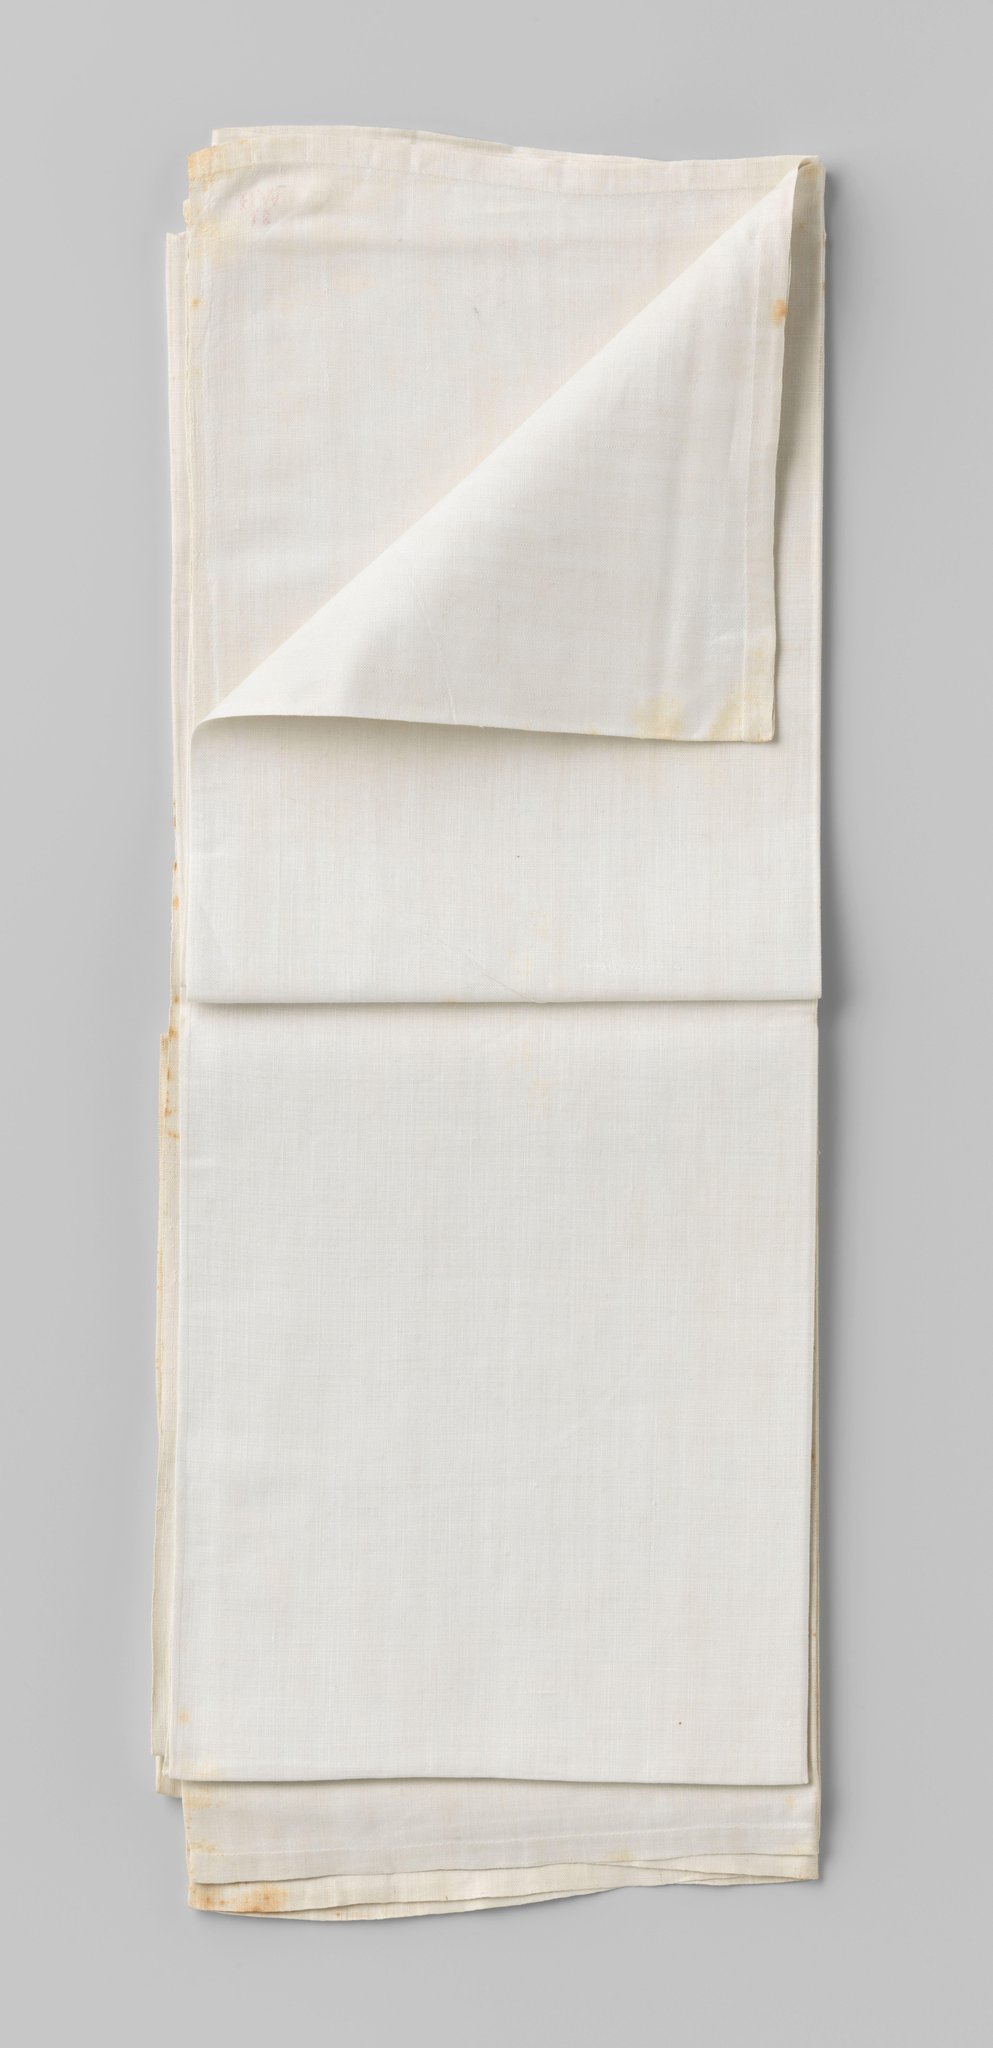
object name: kinderlaken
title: Kinderlaken. Merk: HW 18.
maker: Anonymous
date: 1852-1860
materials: linen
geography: northern netherlands